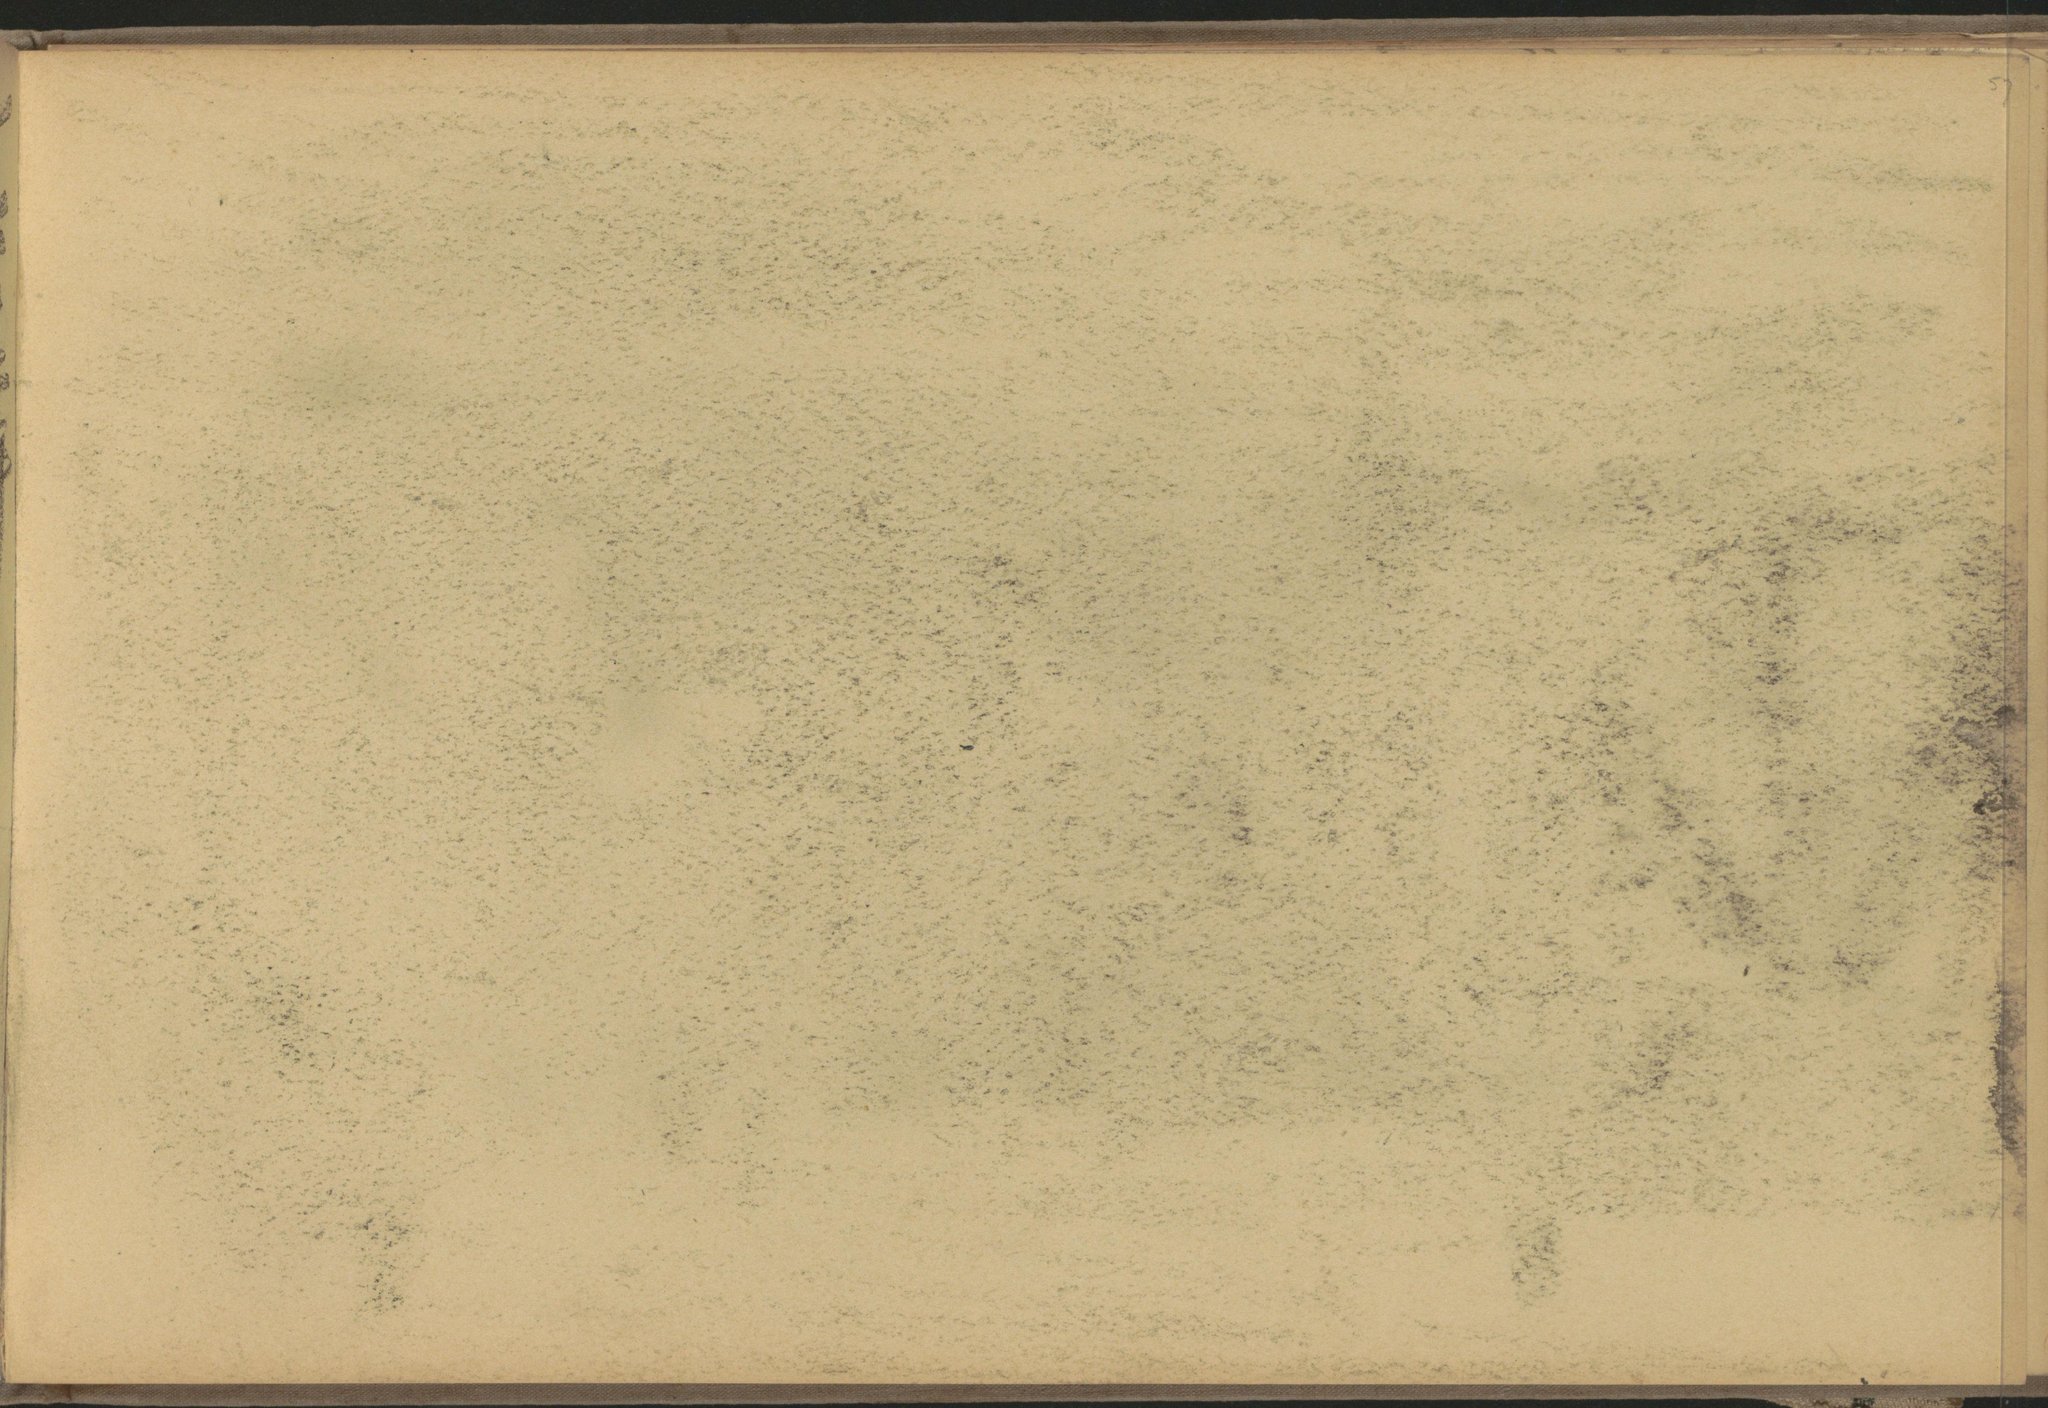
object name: sketchbook leaf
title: Abklatsch van de krijttekening op pagina 56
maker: willem witsen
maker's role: draughtsman, painter, print maker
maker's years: 1860-1923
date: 1901-1907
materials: paper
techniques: printmaking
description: Pagina 57 uit een schetsboek met 60 bladen.